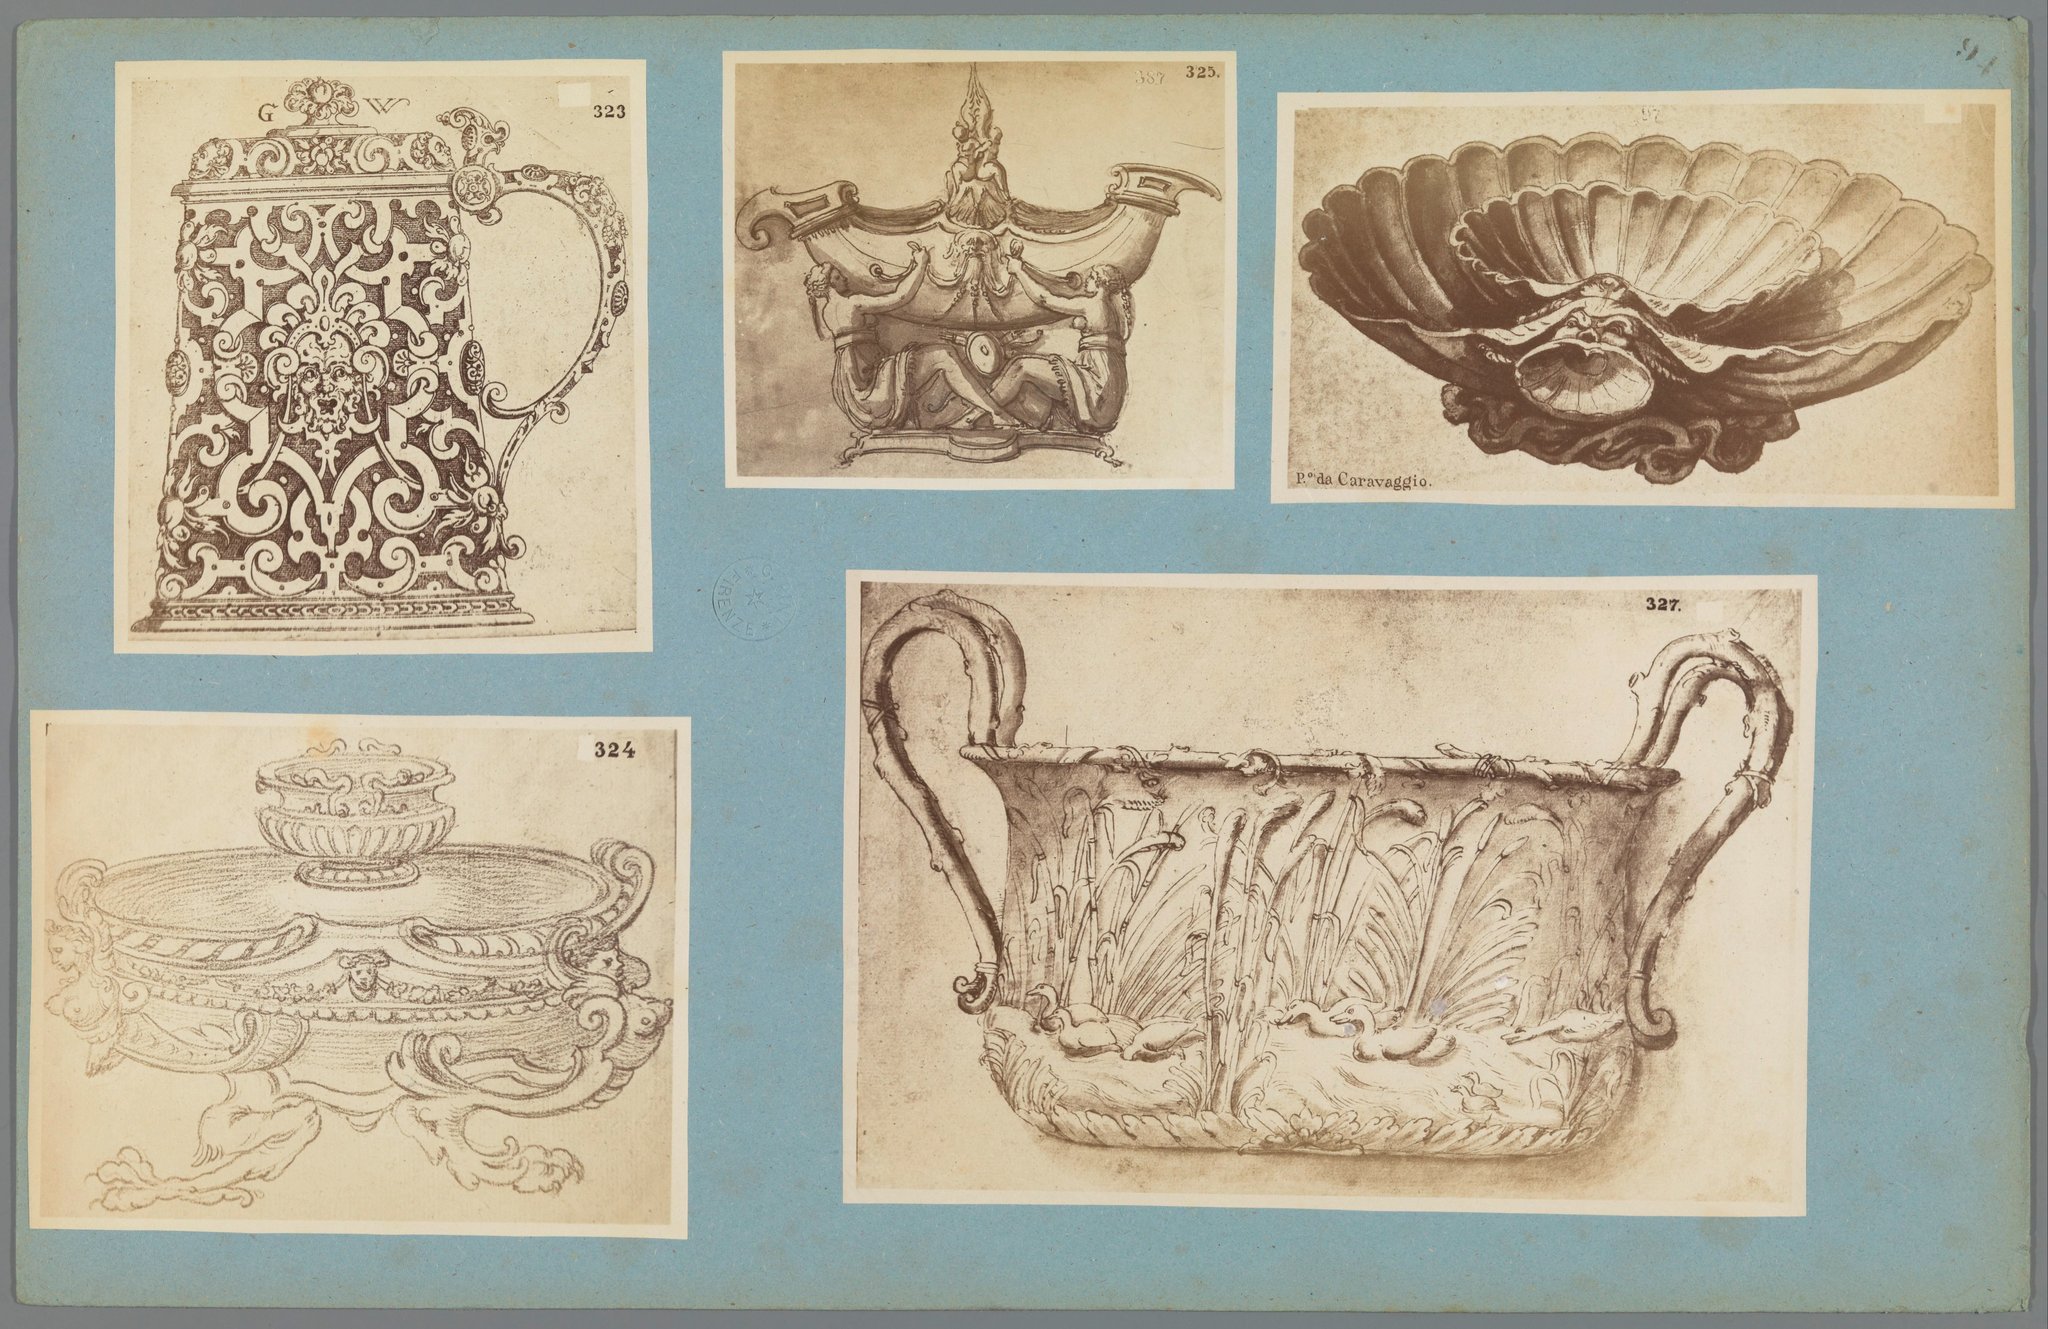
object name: reproduction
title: Vijf fotoreproducties van een prent en tekeningen van vaatwerk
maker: Anonymous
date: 1875-1900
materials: cardboard, photographic support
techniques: albumen print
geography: europe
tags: containers, mug, beaker, goblet, scallop, shell ~ ornament, bowl, europe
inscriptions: number: ‘325.’, number: ‘94’, number: ‘324’, name: ‘C. PINI FIRENZE’, number: ‘327.’, collector's mark: Lugt 3937, number: ‘323’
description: Linksboven (323) een prent van een pul met deksel, linksonder een tekening van (vermoedelijk) een vat met gevleugelde vrouwenfiguren, middenboven (325) een tekening van (vermoedelijk) een vat met twee zittende vrouwen, rechtsboven een tekening van een schelpenvorm, rechtsonder (327) een tekening van een vat met een voorstelling van eenden.